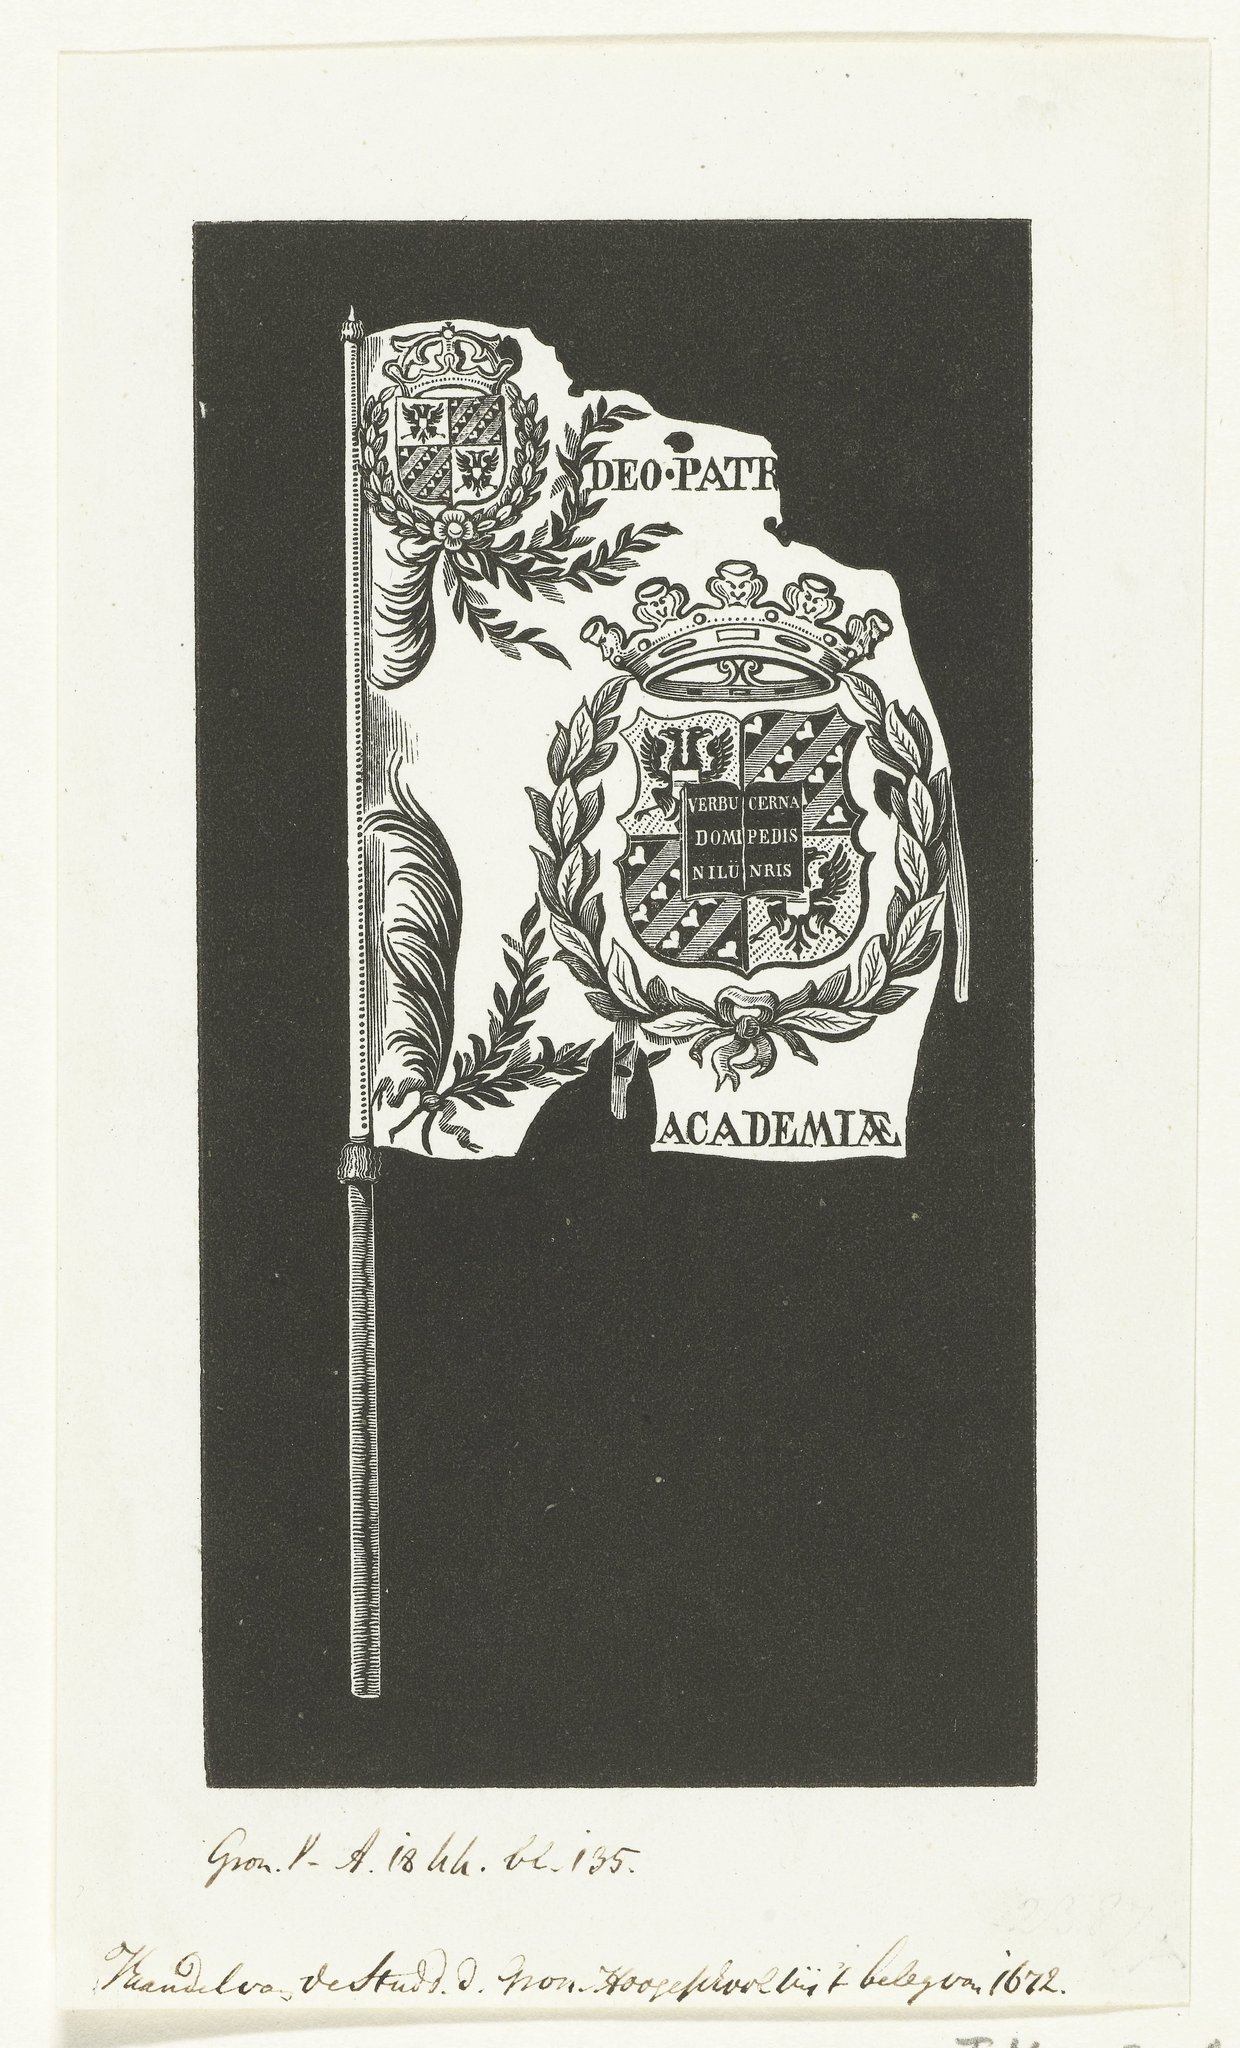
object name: historical object representation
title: Studentenvaandel gevoerd tijdens het beleg van Groningen, 1672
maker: Anonymous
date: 1842-1844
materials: paper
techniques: woodcut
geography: netherlands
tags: banner, standard (as symbol of the state, etc.), (military) flags and standards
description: Overblijfsel van het vaandel van de studenten van de Hoge School te Groningen, gevoerd tijdens het beleg van Groningen door de bisschoppen van Keulen en Munster gedurende de maanden juli en augustus van het jaar 1672.